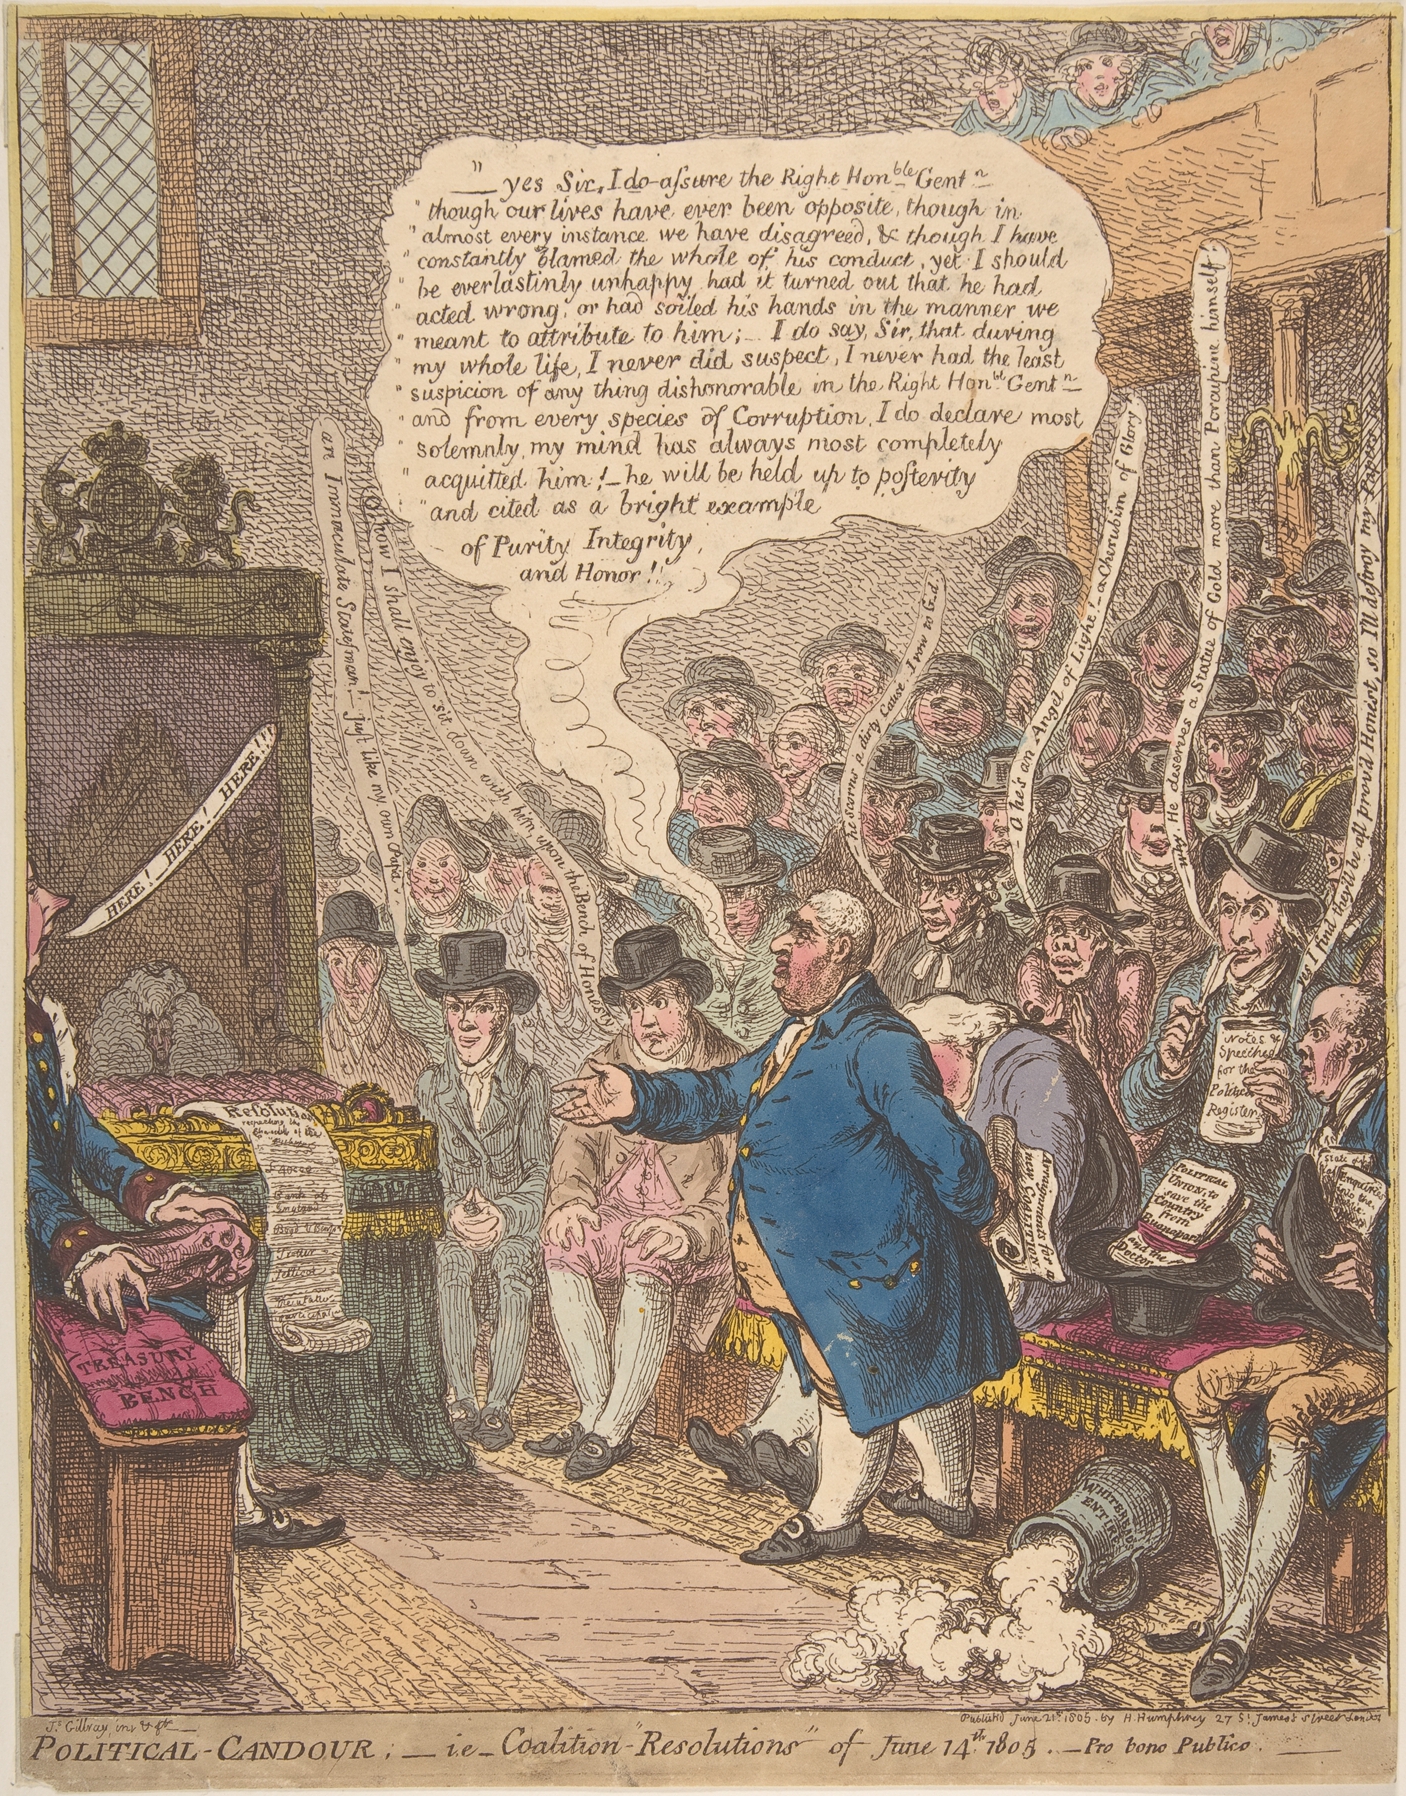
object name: print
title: Political-Candour;– i.e.–Coalition-Resolutions of June 14th, 1805.–Pro bono Publico–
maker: james gillray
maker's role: artist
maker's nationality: british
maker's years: 1756-1815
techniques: etching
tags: satire,men,politics